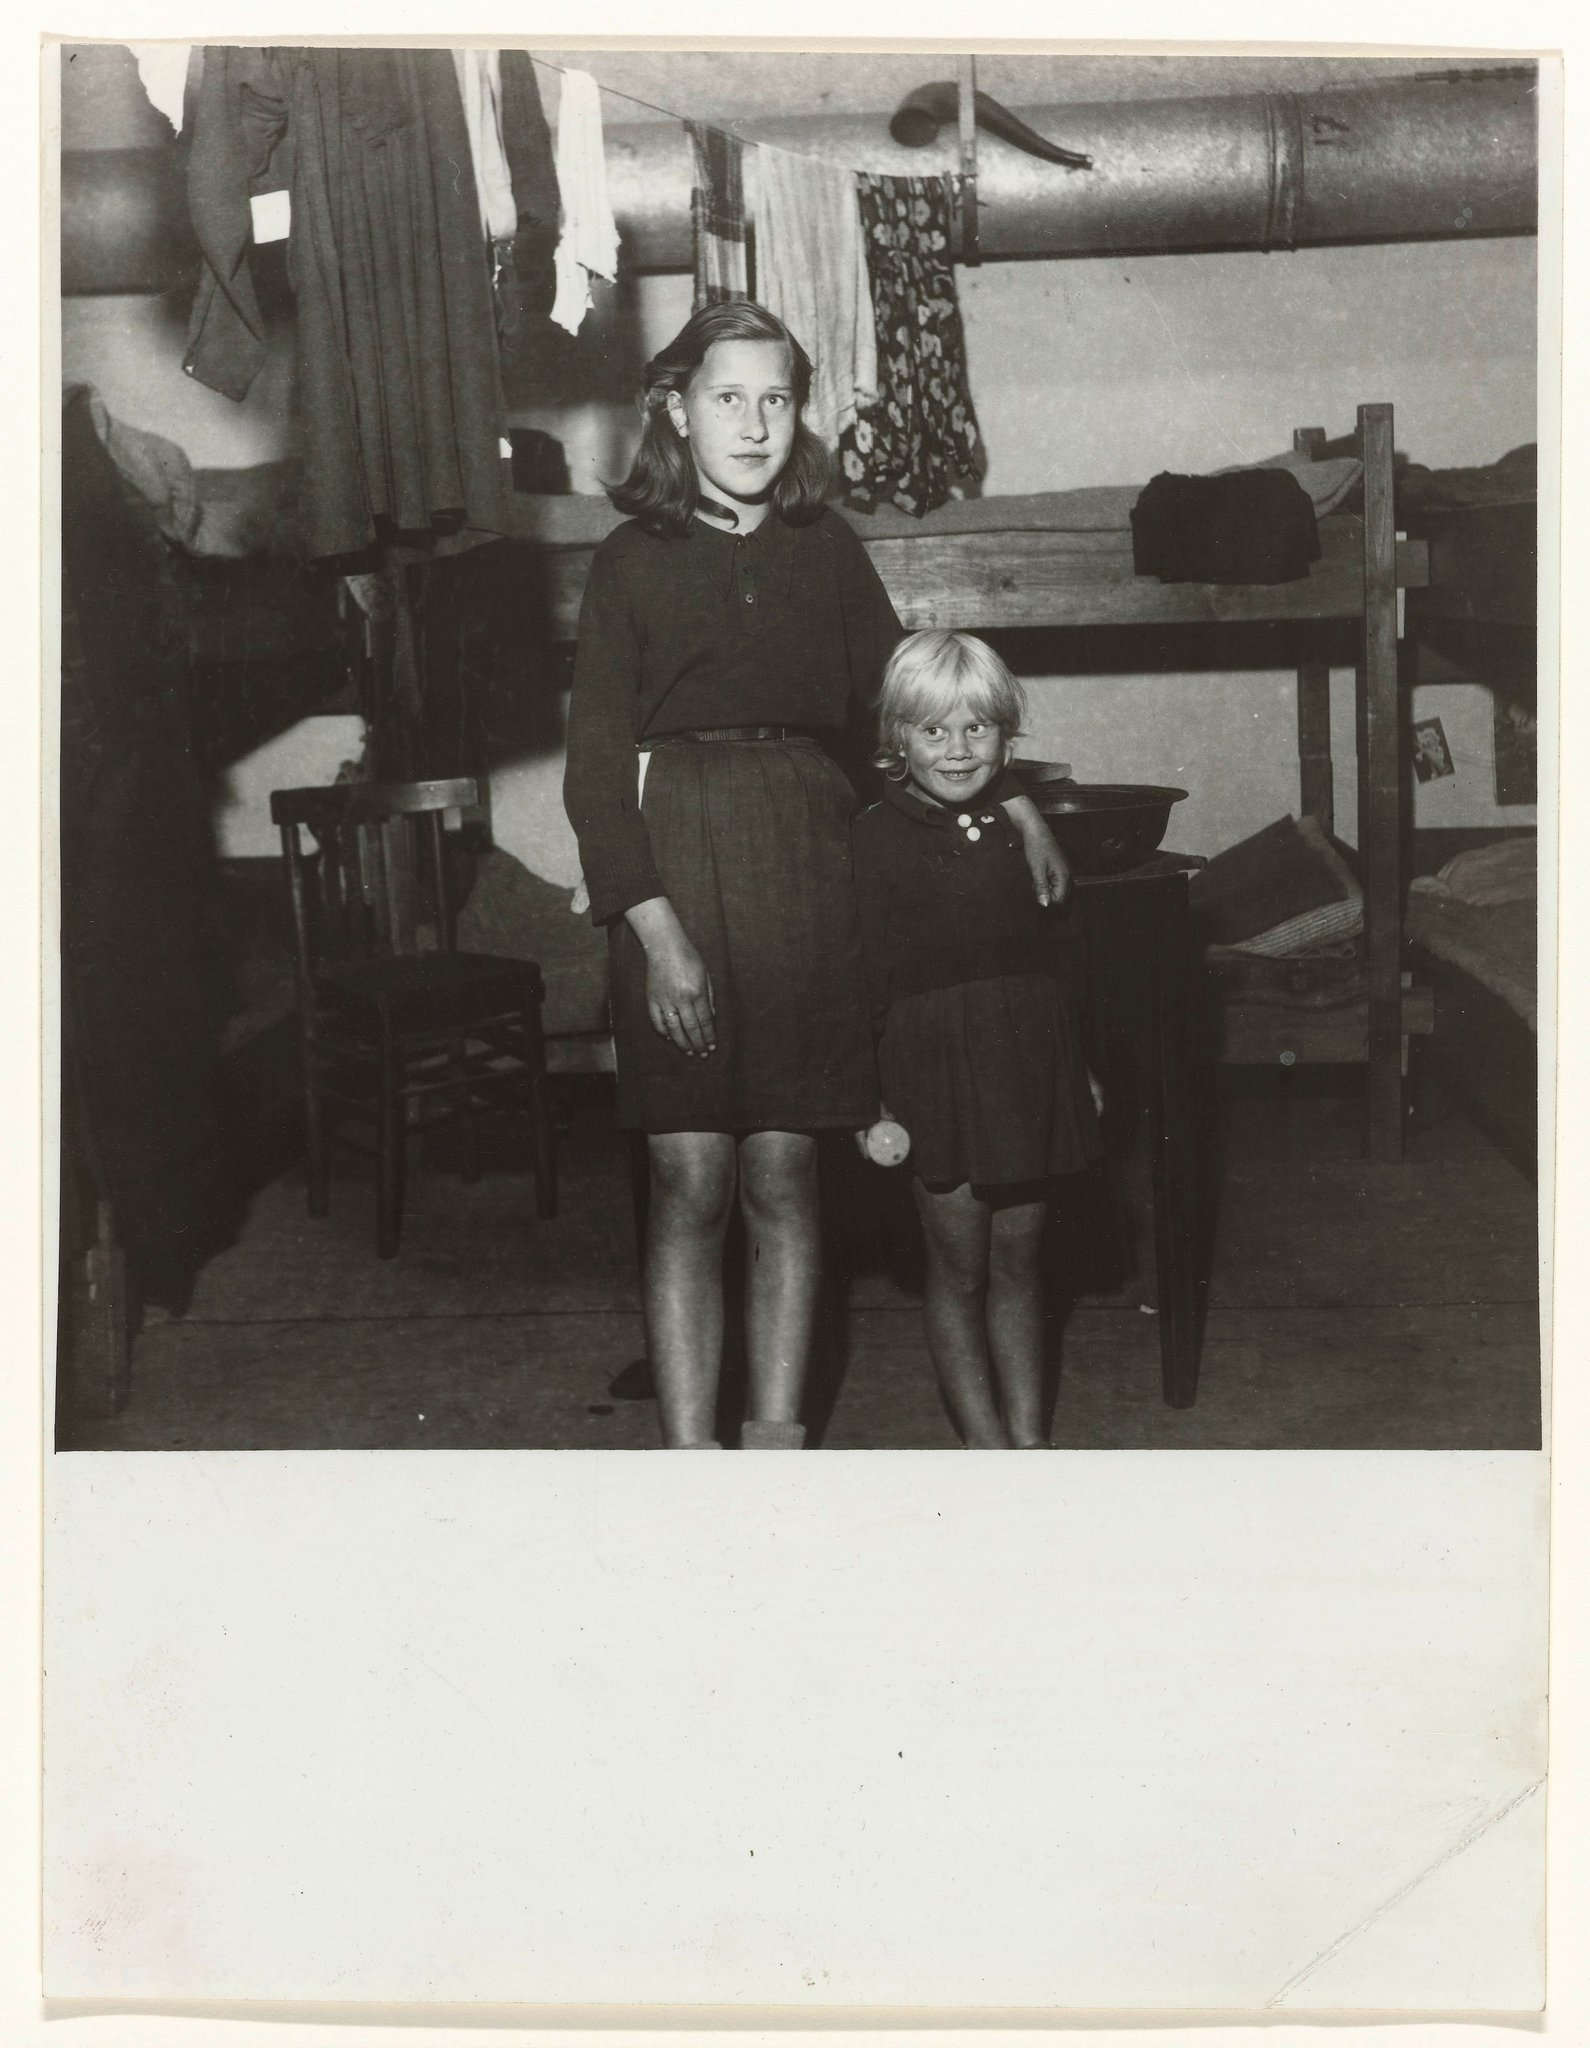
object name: documentary photograph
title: Twee meisjes bij een stapelbed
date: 1945-1947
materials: photographic support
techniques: photography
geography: netherlands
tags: netherlands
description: Twee glimlachende meisjes staan voor een stapelbed. Boven hun hoofd hangt wasgoed. Langs de muur achter hen loopt een dikke buis.